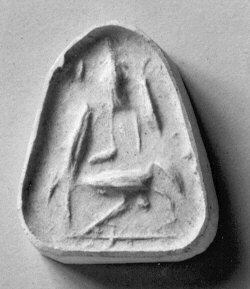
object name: stamp seal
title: Stamp seal (rounded triangular base with loop handle) with anthropomorphic figure and animals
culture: syro-anatolian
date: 900-601 BCE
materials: stone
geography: northern syria or southeastern anatolia